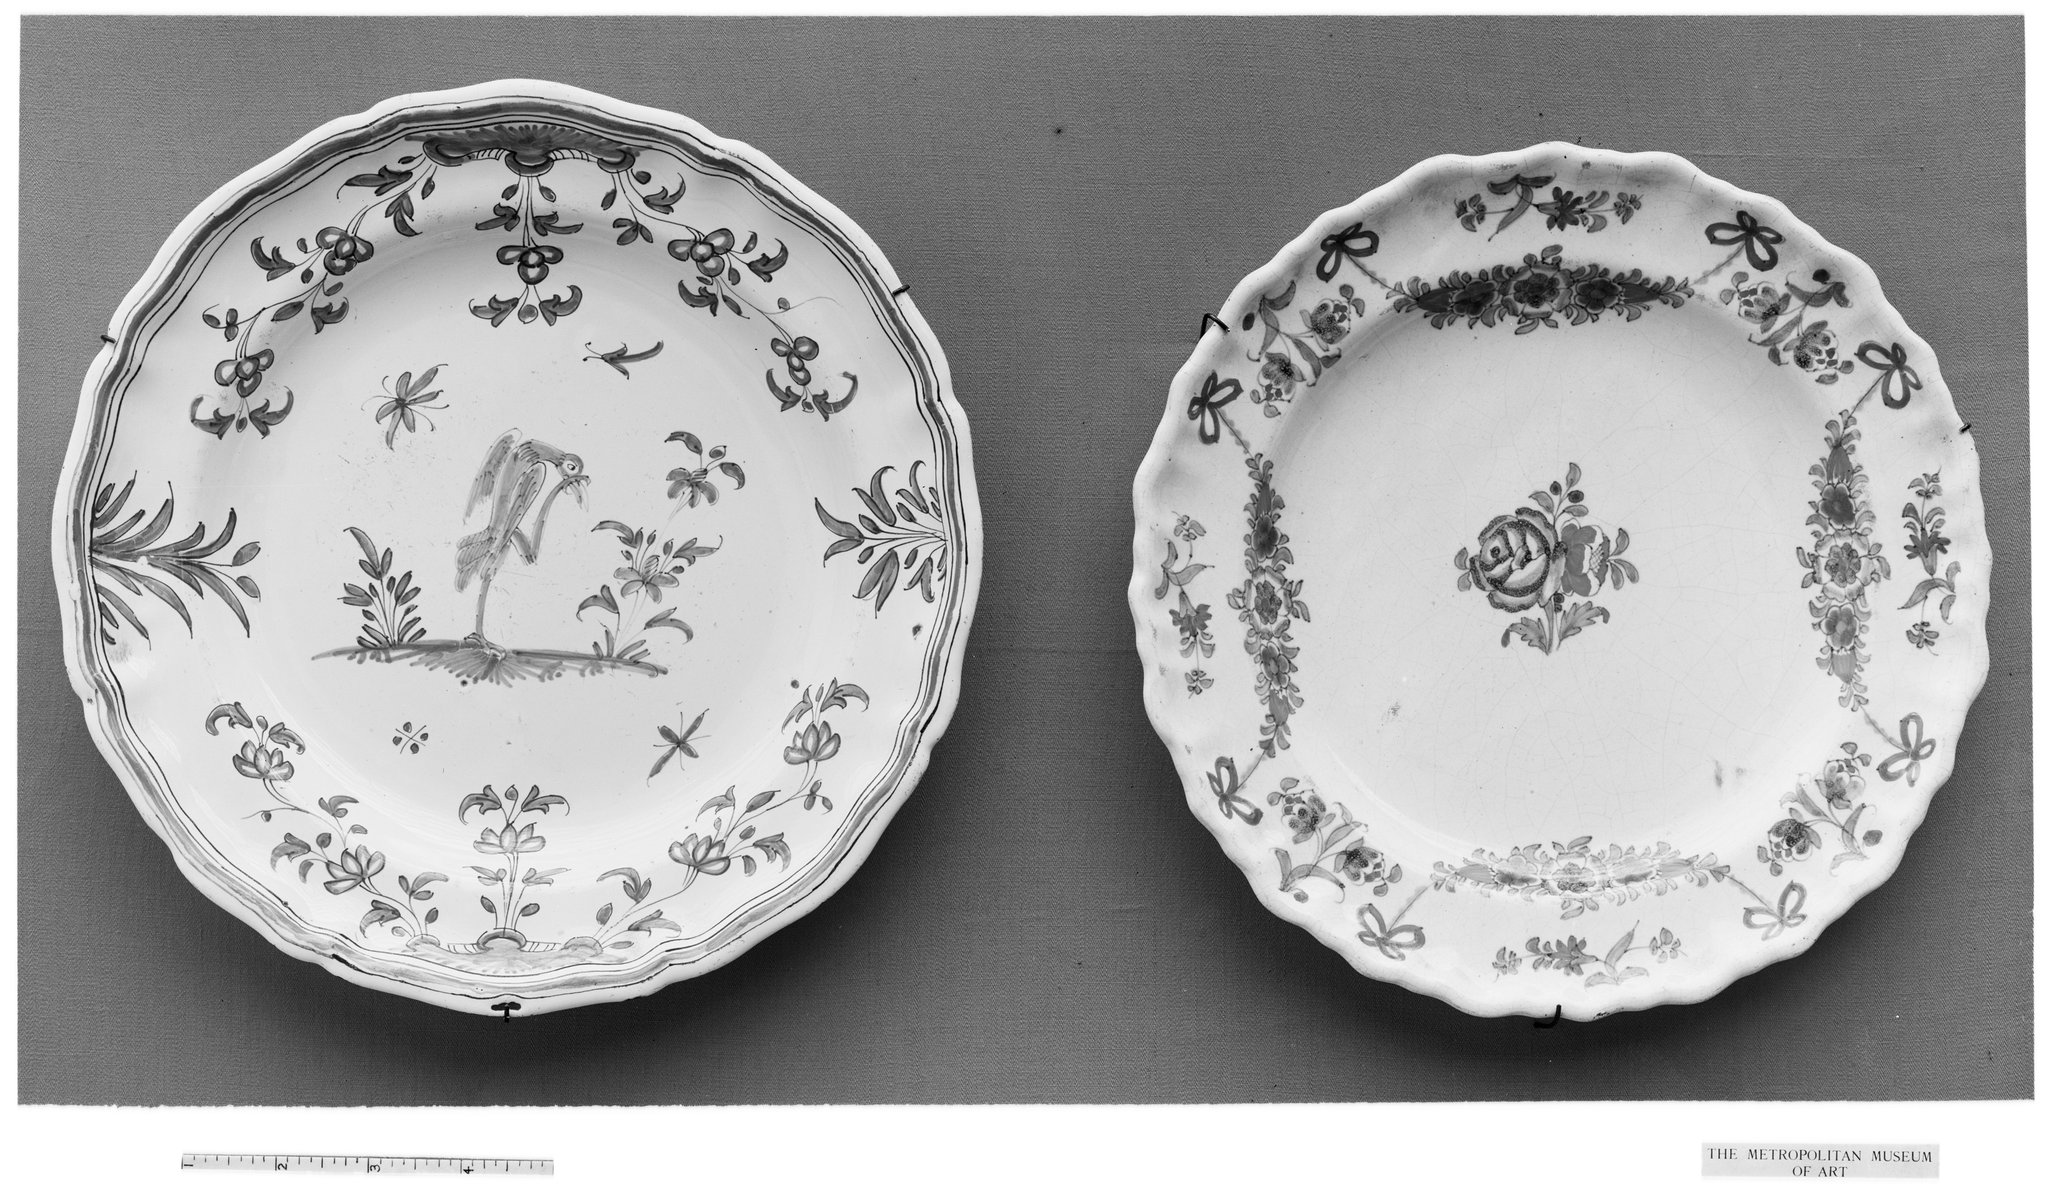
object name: plate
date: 1750-1775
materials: faience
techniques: glazing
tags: birds,flowers